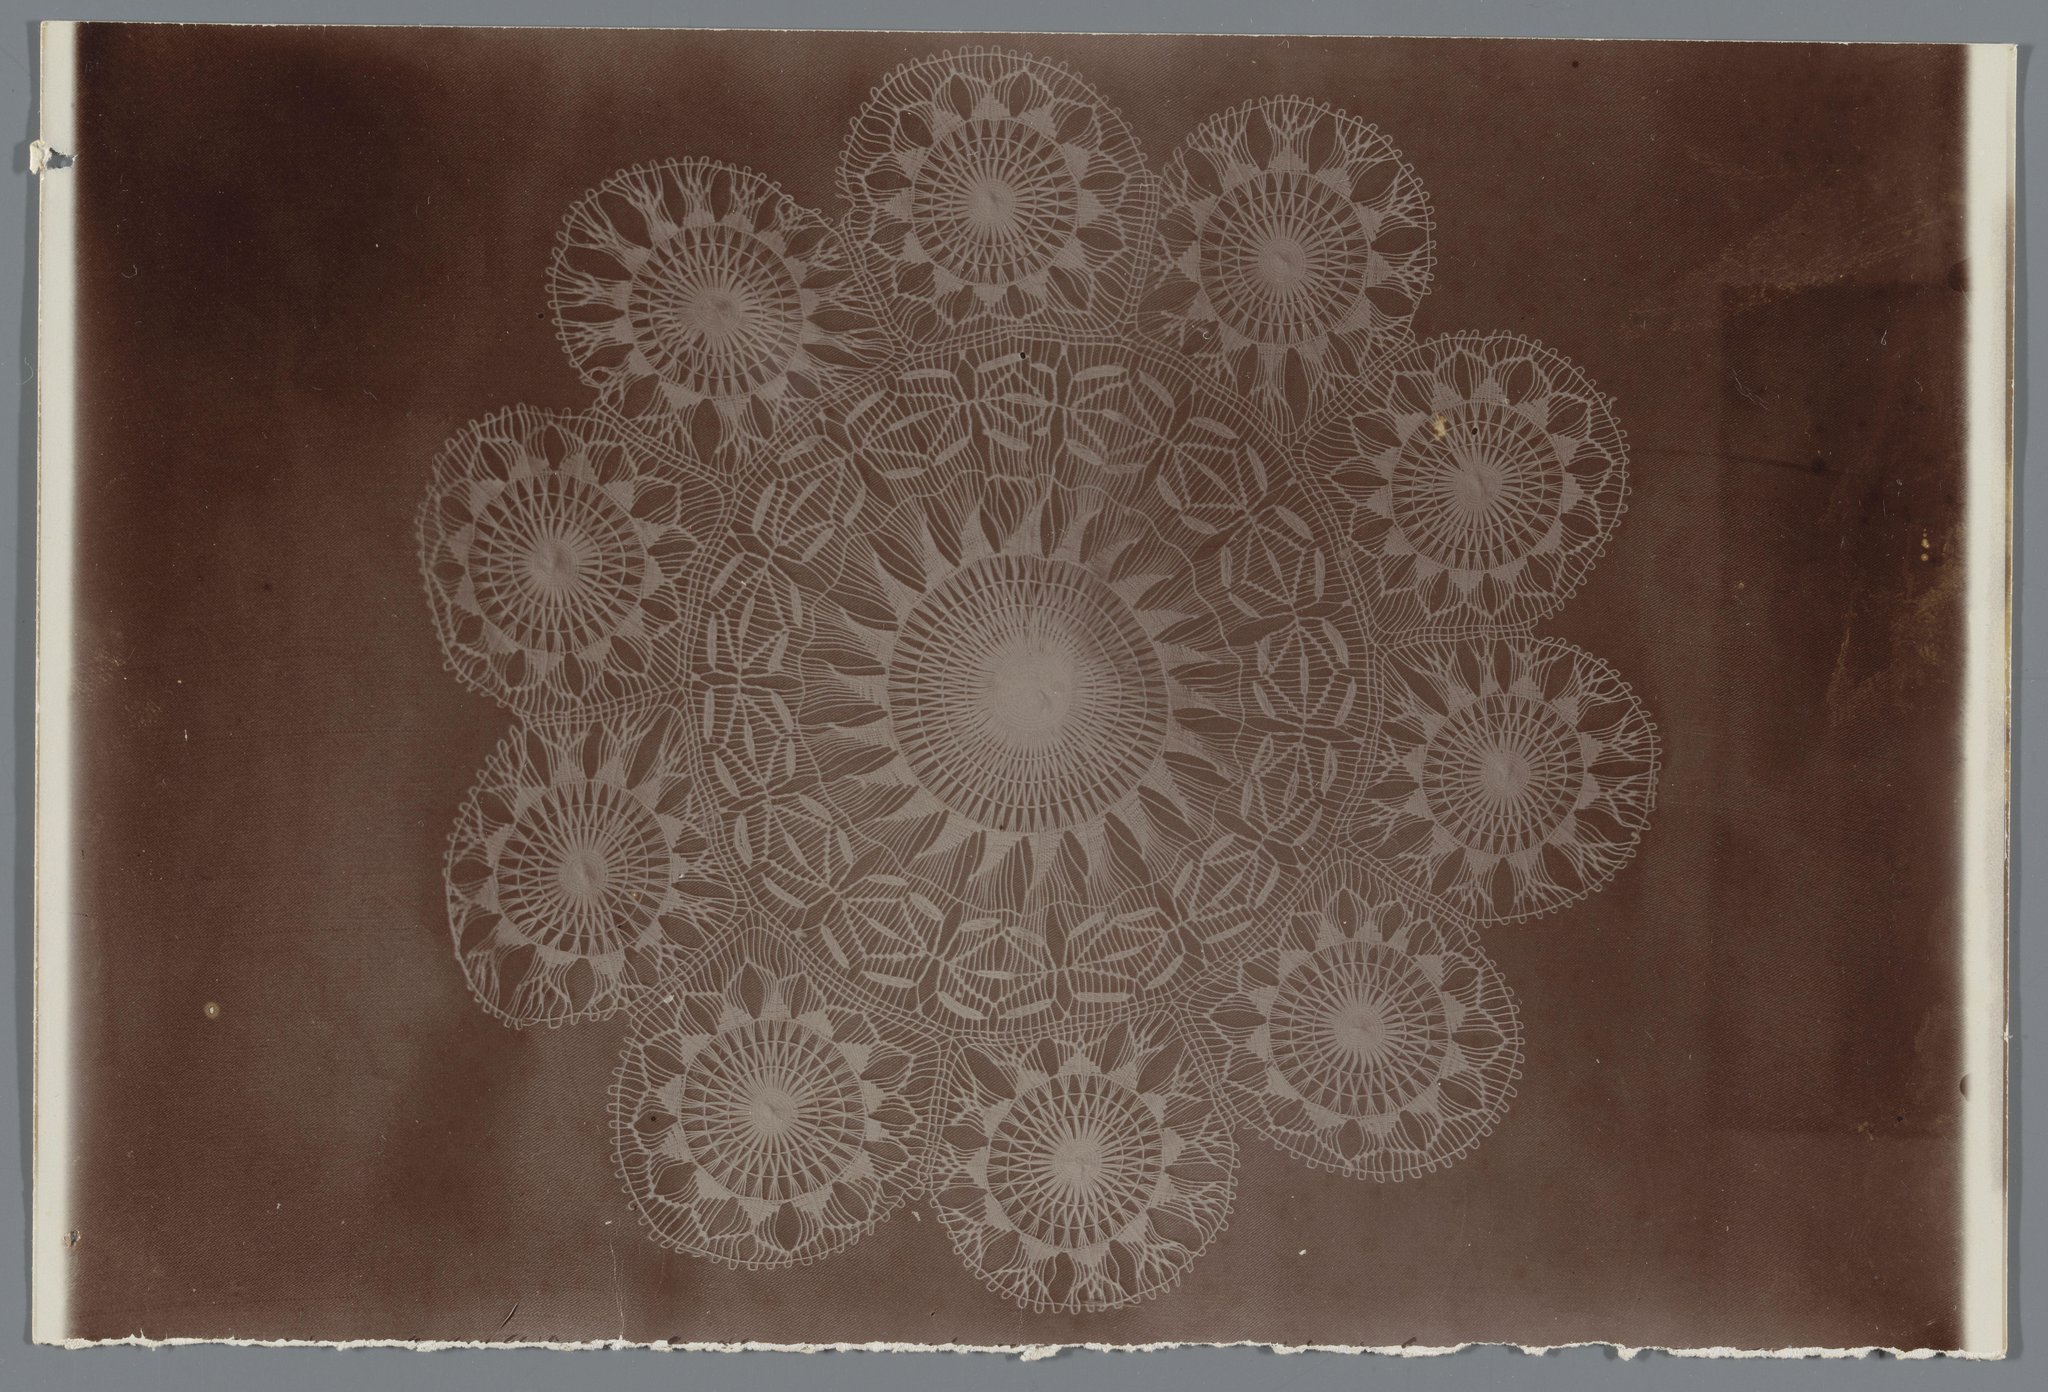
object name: photograph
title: Kleed van kant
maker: Anonymous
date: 1890-1920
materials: paper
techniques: collodion silver print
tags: lace